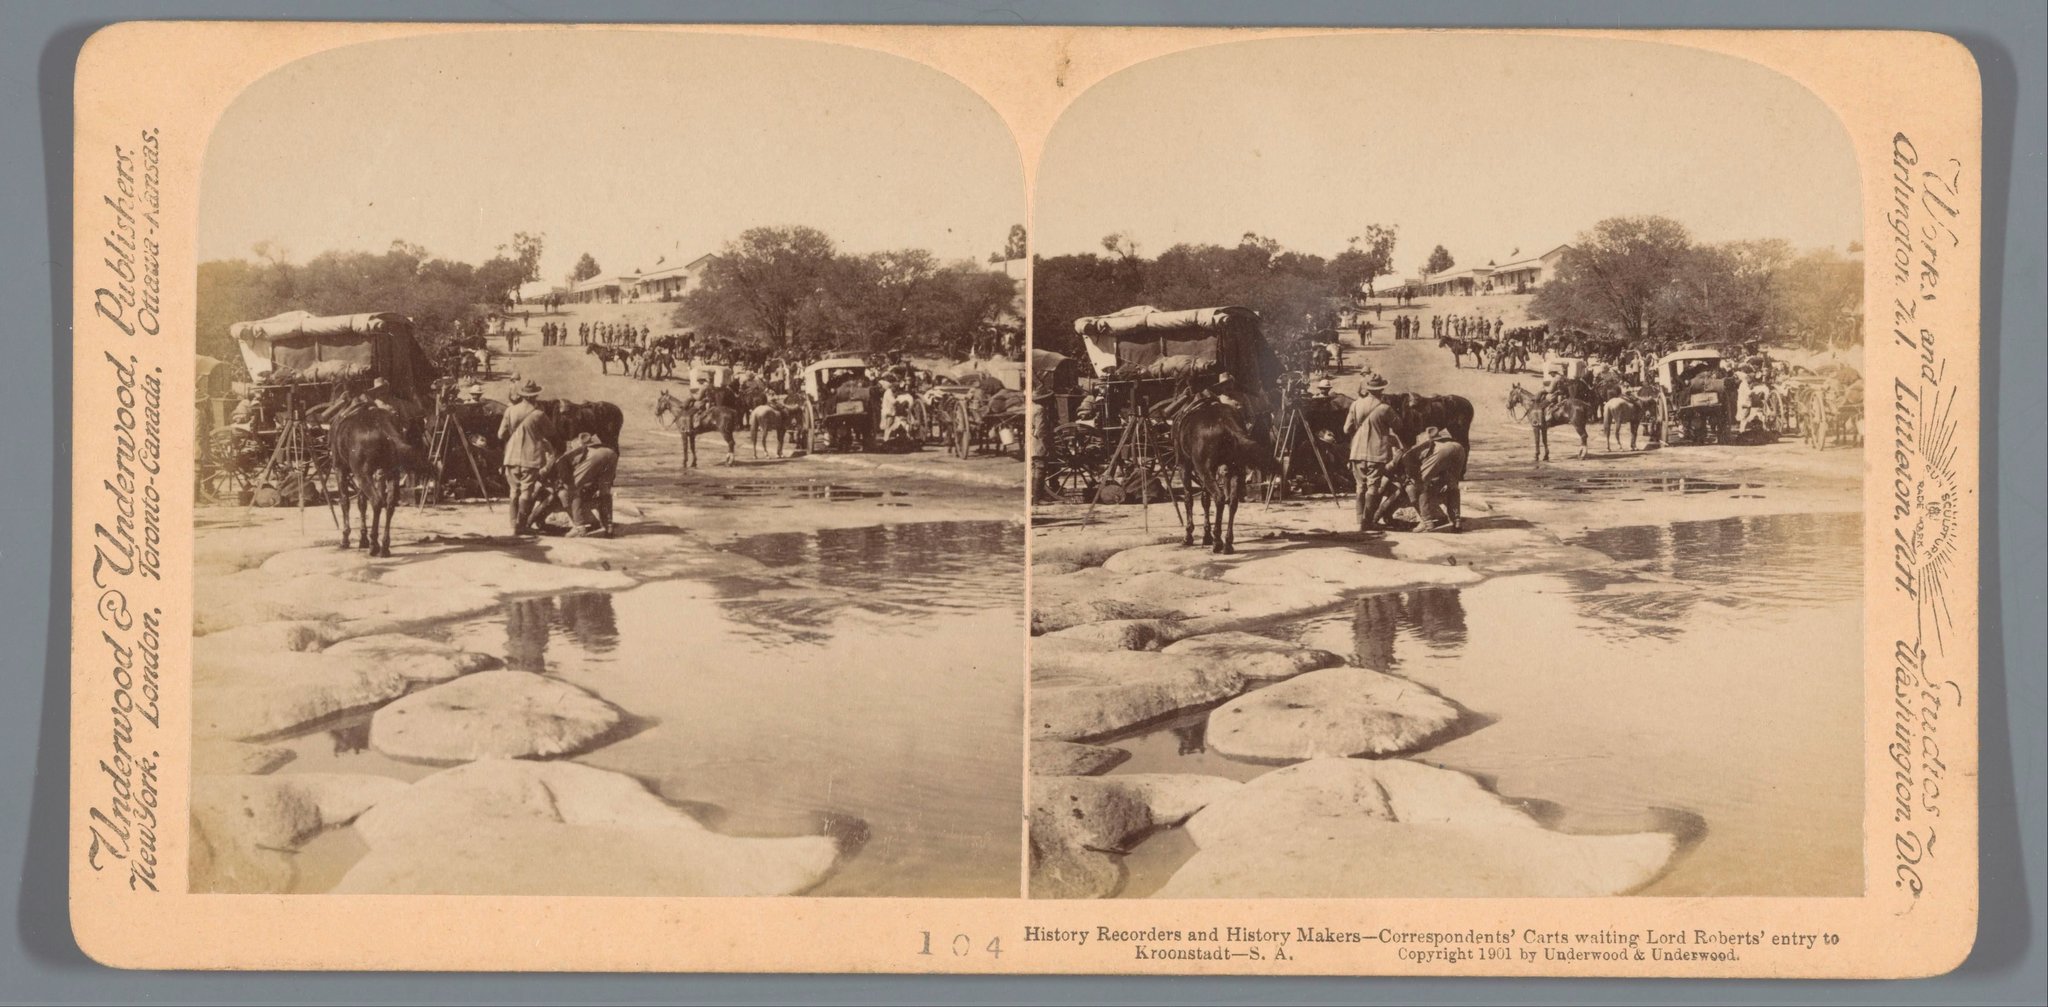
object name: stereograph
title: History Recorders and History Makers, Correspondents' Carts waiting Lord Roberts' entry to Kroonstadt, S.A.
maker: Anonymous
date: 1901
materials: cardboard, paper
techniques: albumen print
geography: kroonstad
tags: troop movements, transportation, river bank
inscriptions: inscription: ‘Works and Studios ~/ Arlington, N.J. Littleton, N.H. Washington, D.C.’, copyright notice: ‘Copyright 1901 by Underwood & Underwood.’, inscription, number: ‘104’